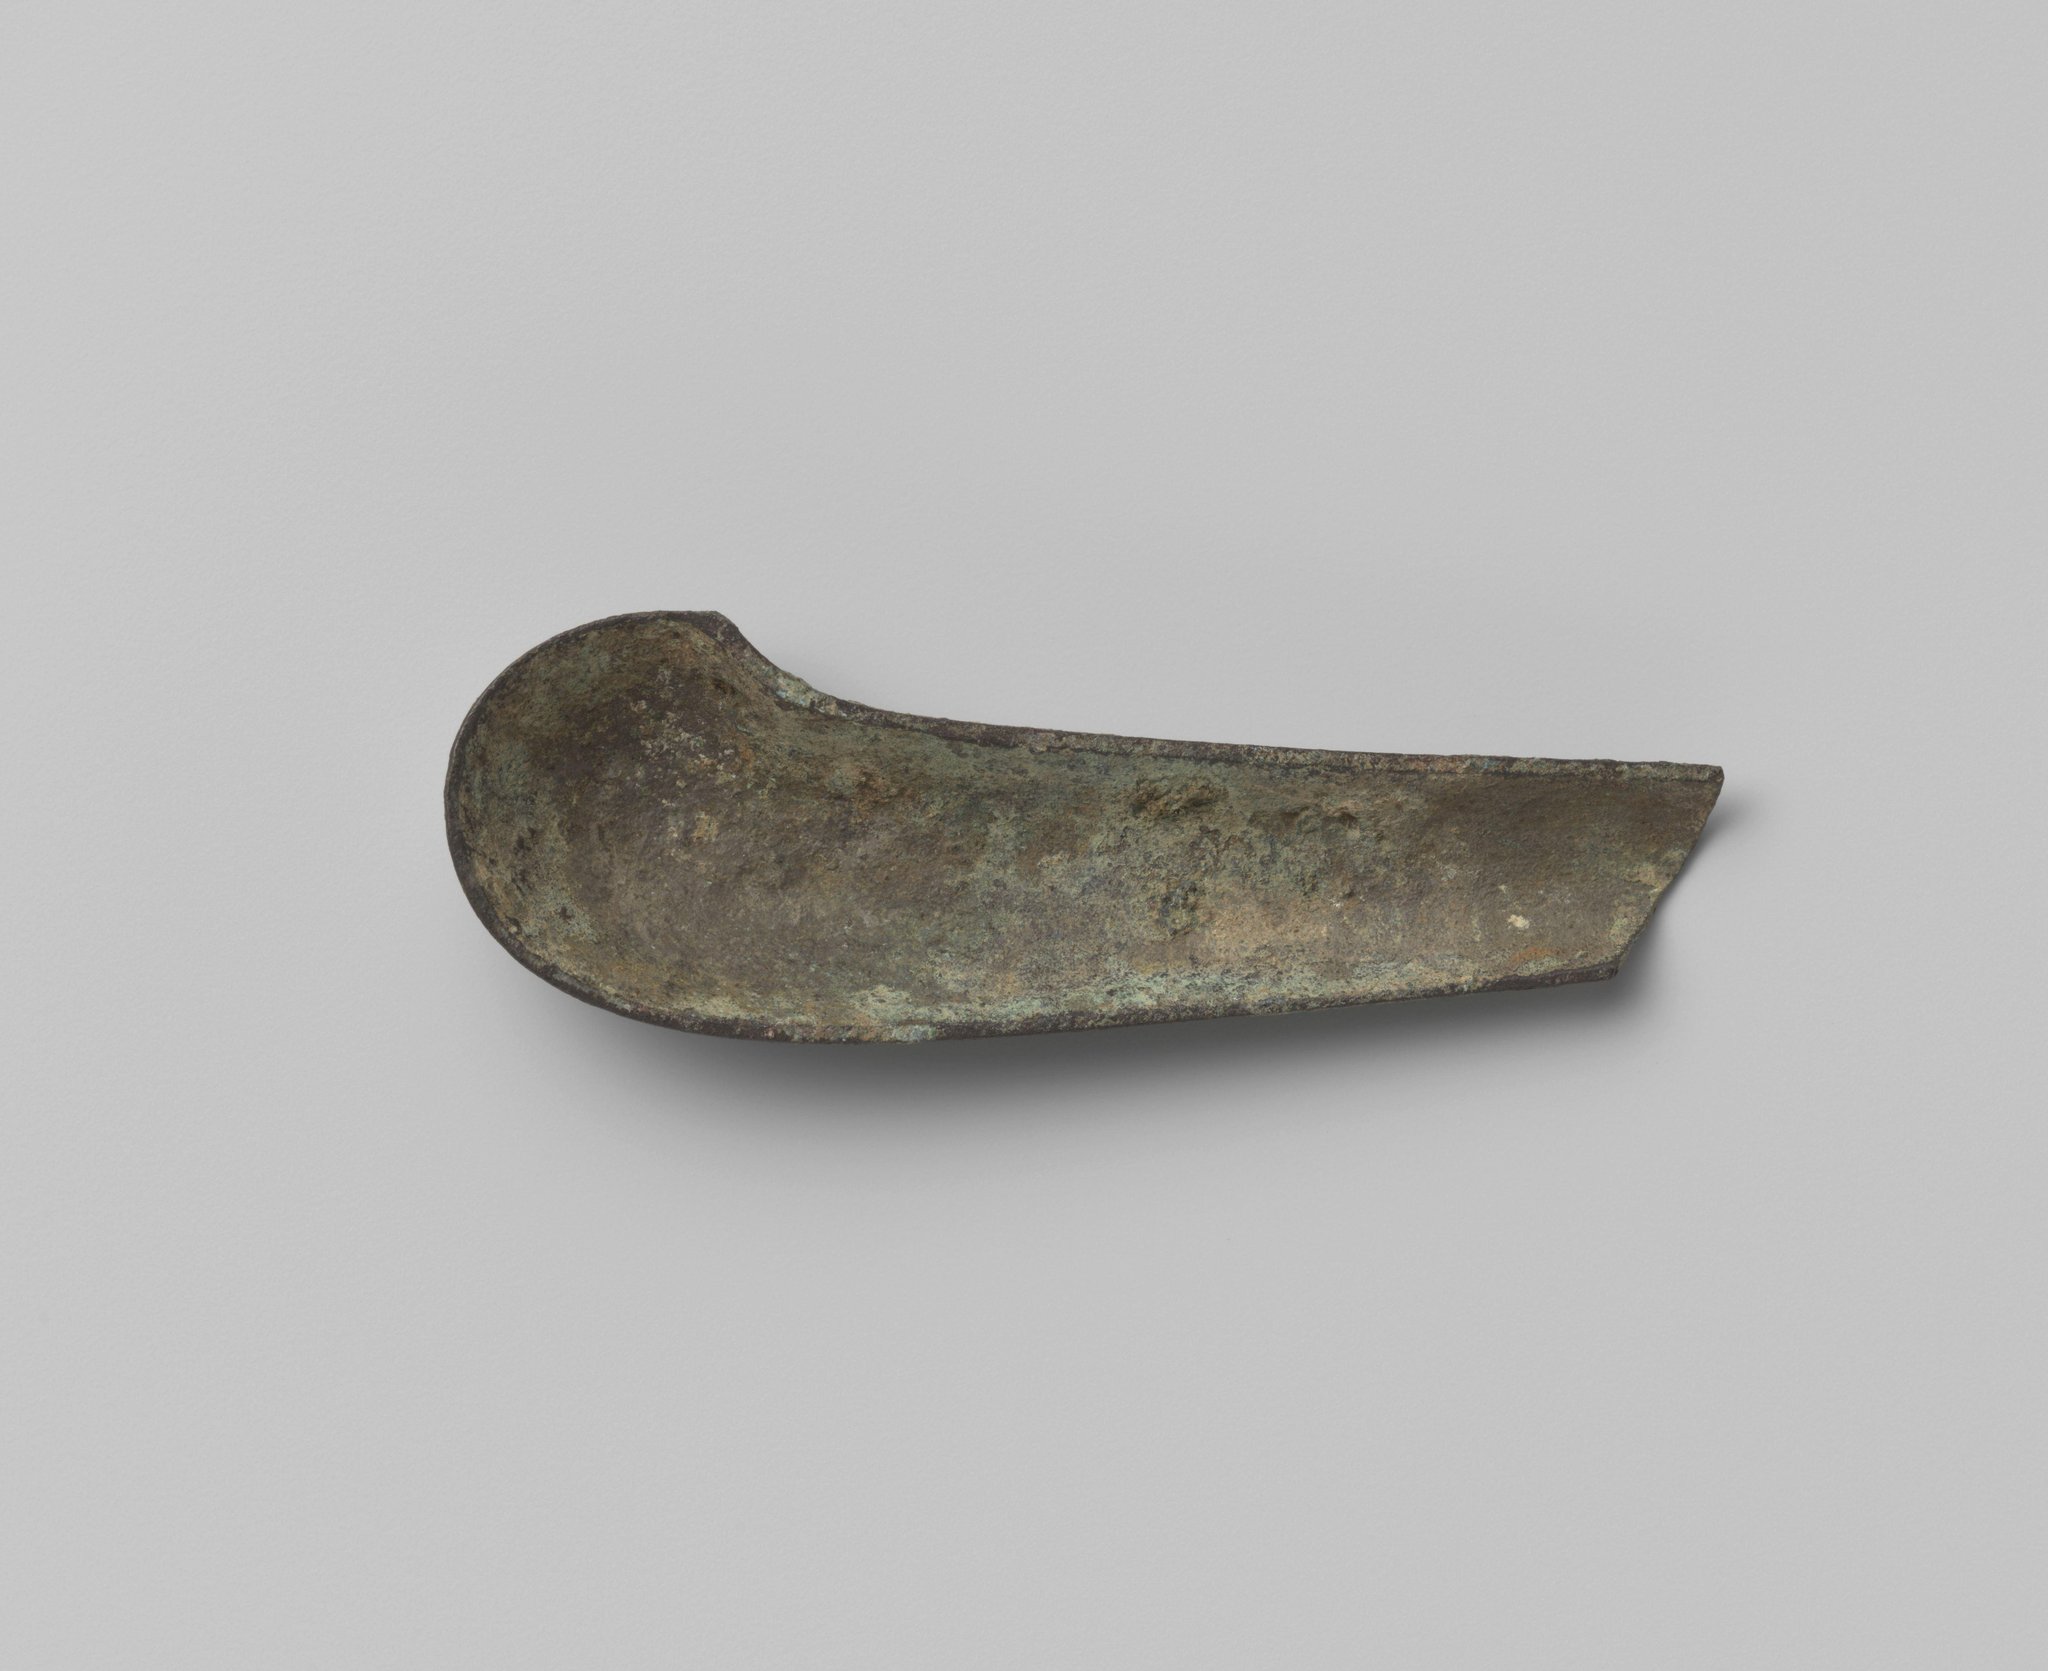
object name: fragment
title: Heft, slechts de helft, van een mes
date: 1400-1950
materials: bronze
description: Een helft of zijde van een heft van een mes.